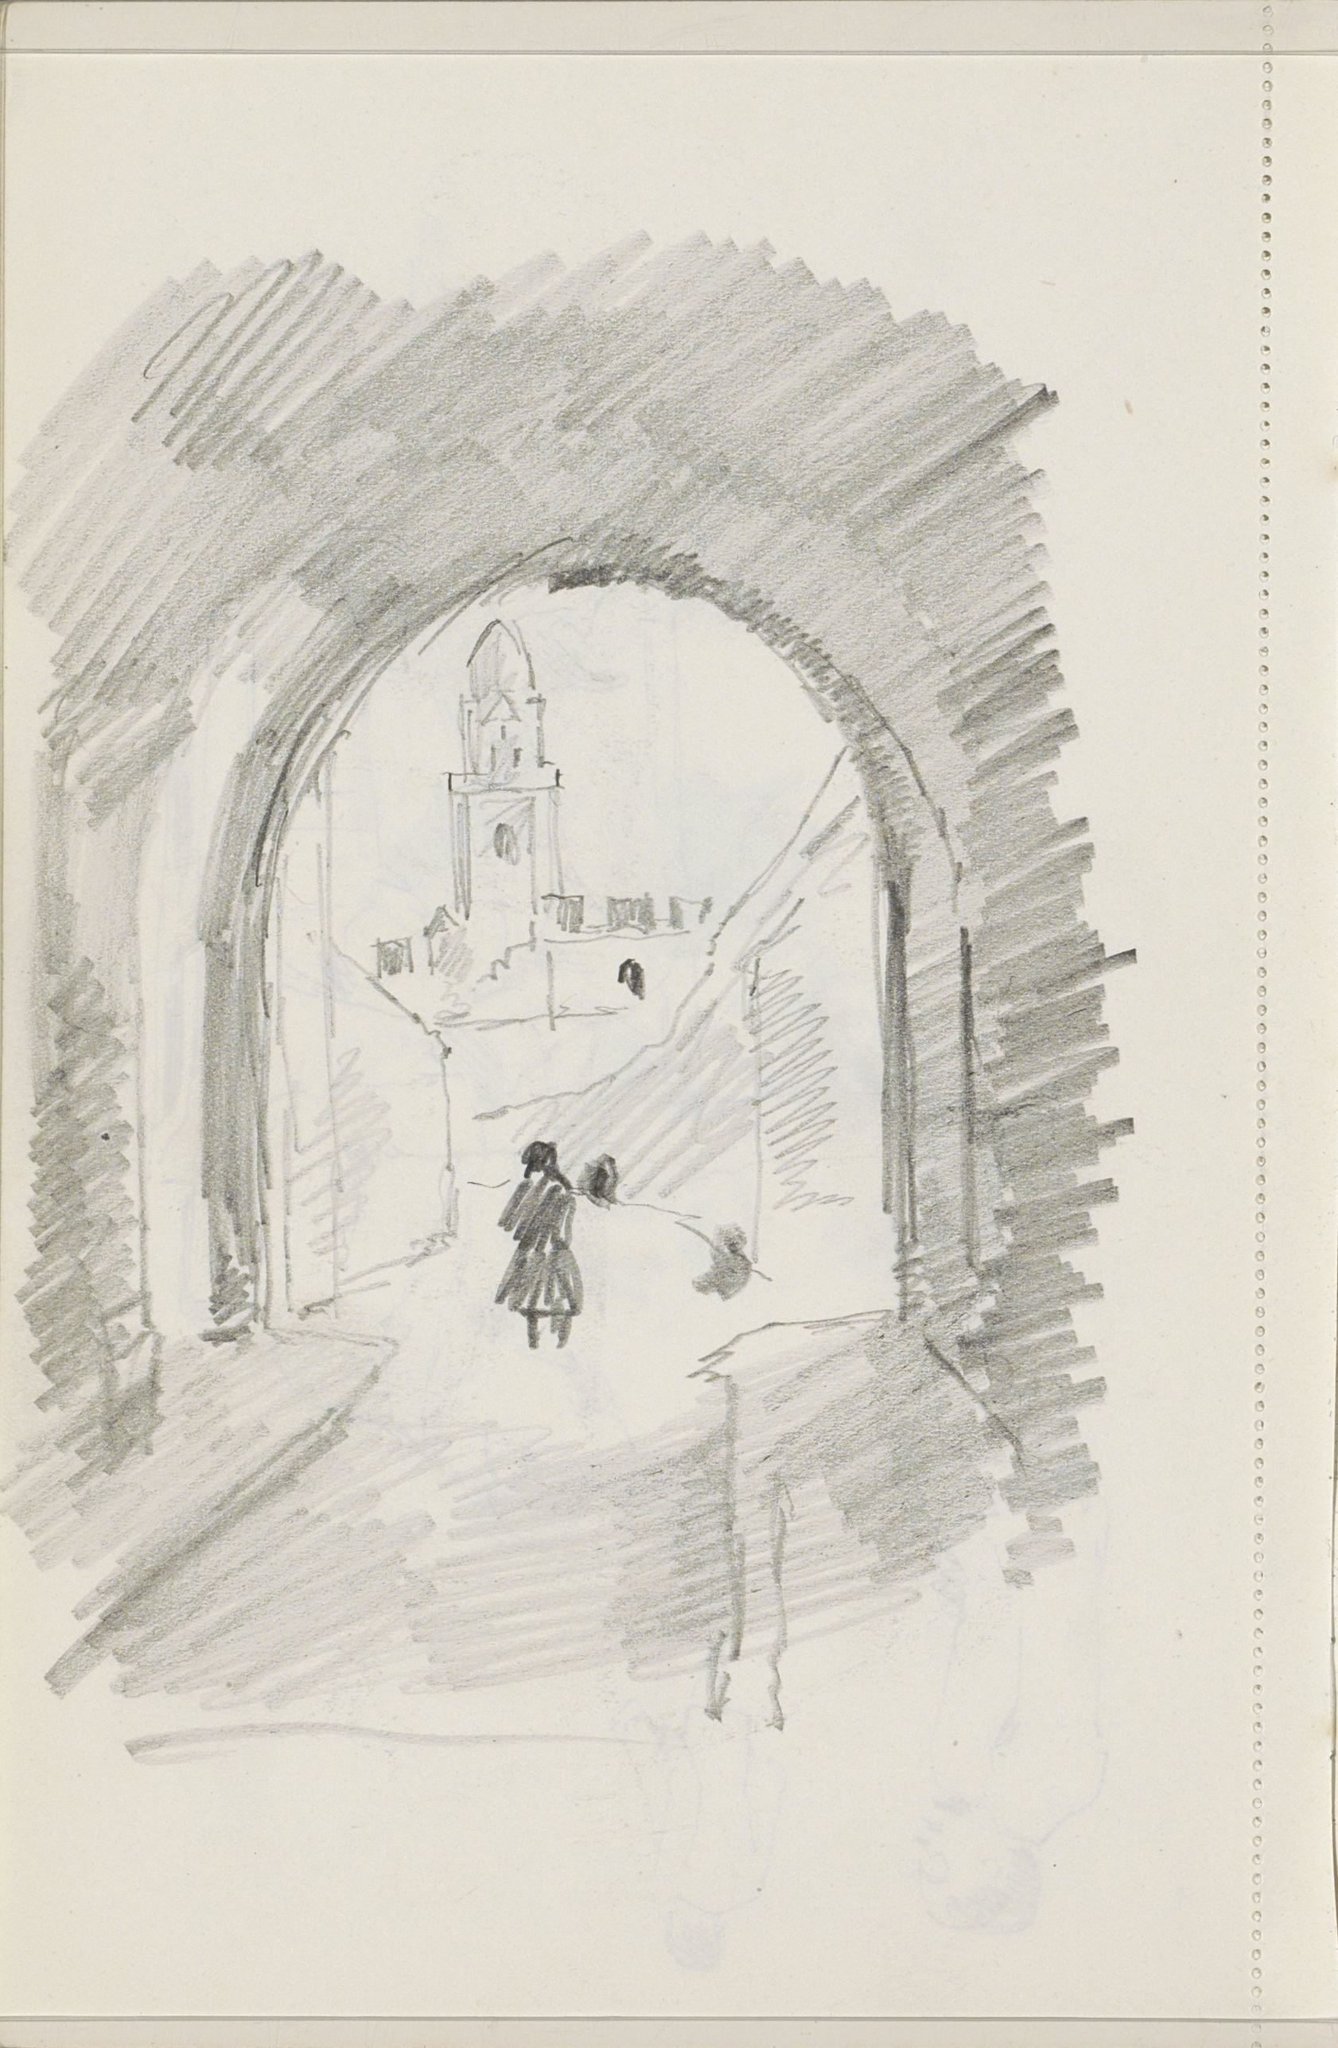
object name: sketchbook leaf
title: Straat gezien door een poort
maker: cornelis vreedenburgh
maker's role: draughtsman, print maker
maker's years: 1880-1946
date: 1935-1936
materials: paper, pencil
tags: tower (of house or building), street (+ city(-scape) with figures, staffage)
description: Op de straat loopt een figuur. Op de achtergrond een toren. Blad 36 verso uit een schetsboek met 73 bladen.